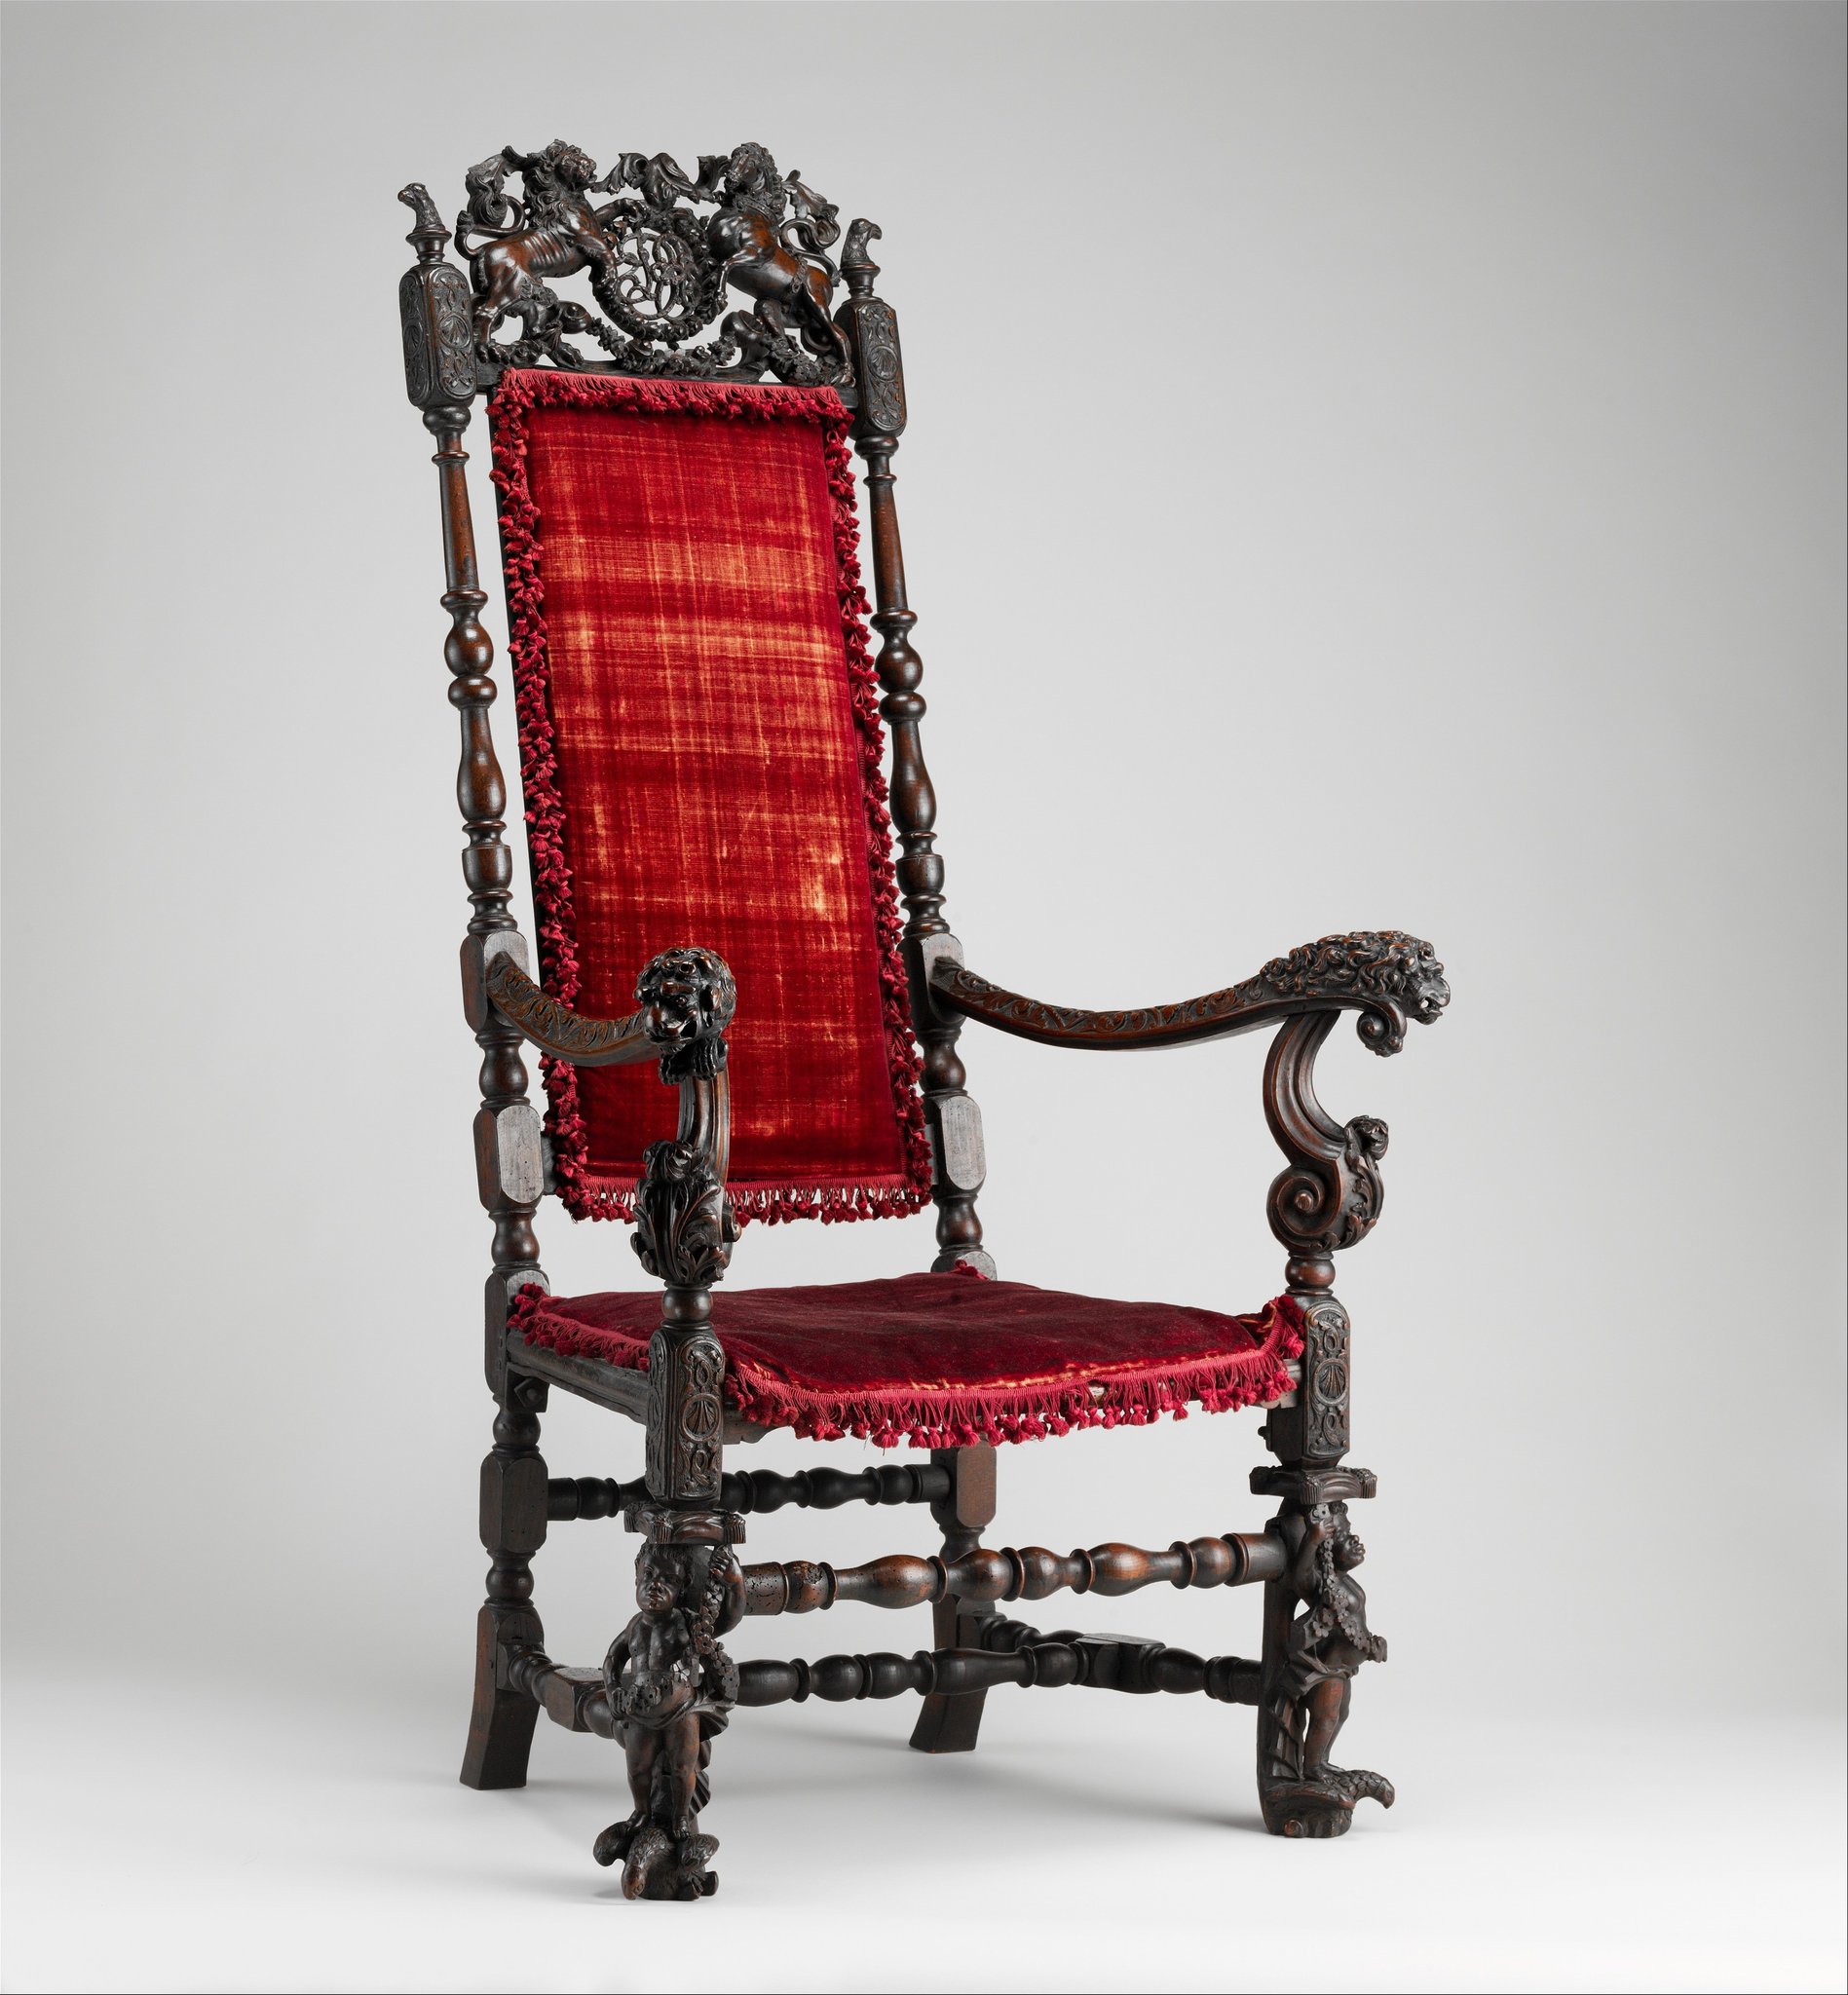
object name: armchair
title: Armchair with the cipher of James II and Mary of Modena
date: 1685-1688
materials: velvet, wood